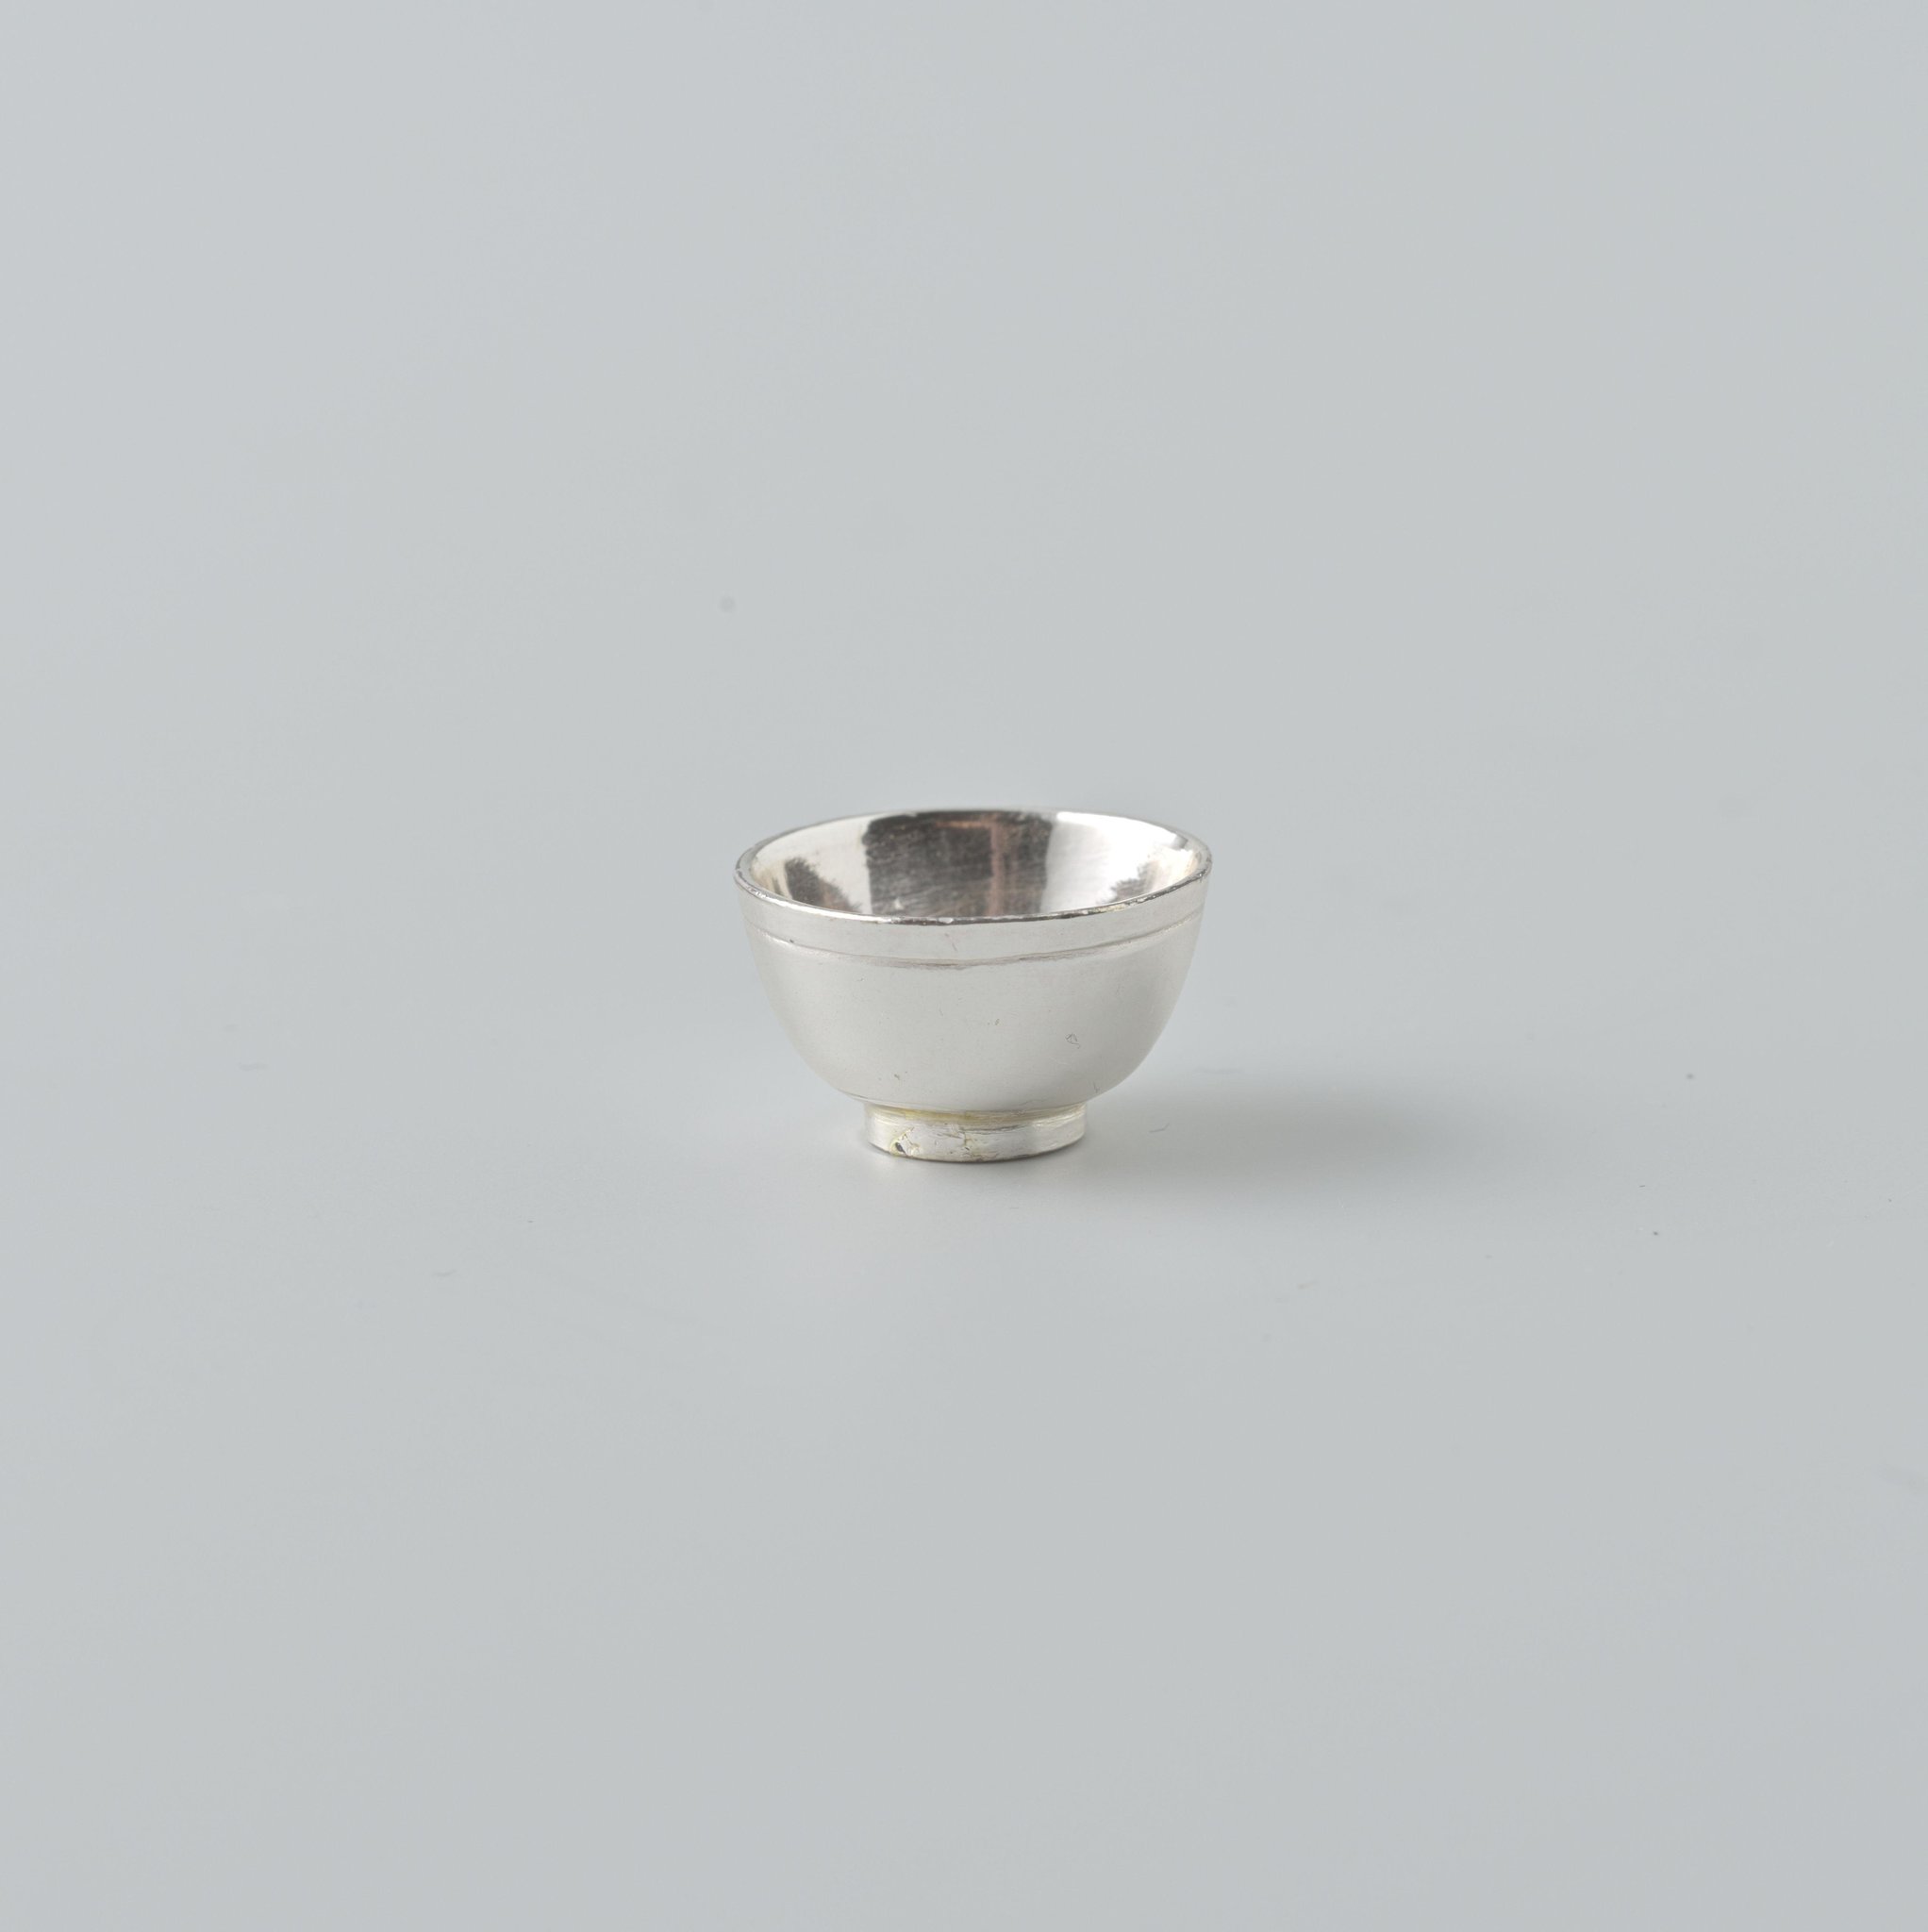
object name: miniature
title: Miniatuurschotel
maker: Anonymous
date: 1765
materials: silver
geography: amsterdam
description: Schotel van zilver, met bijbehorende kom (I). Schotel geheel glad, op standring. Gemerkt: stadsteken Amsterdam; jaarletter F.